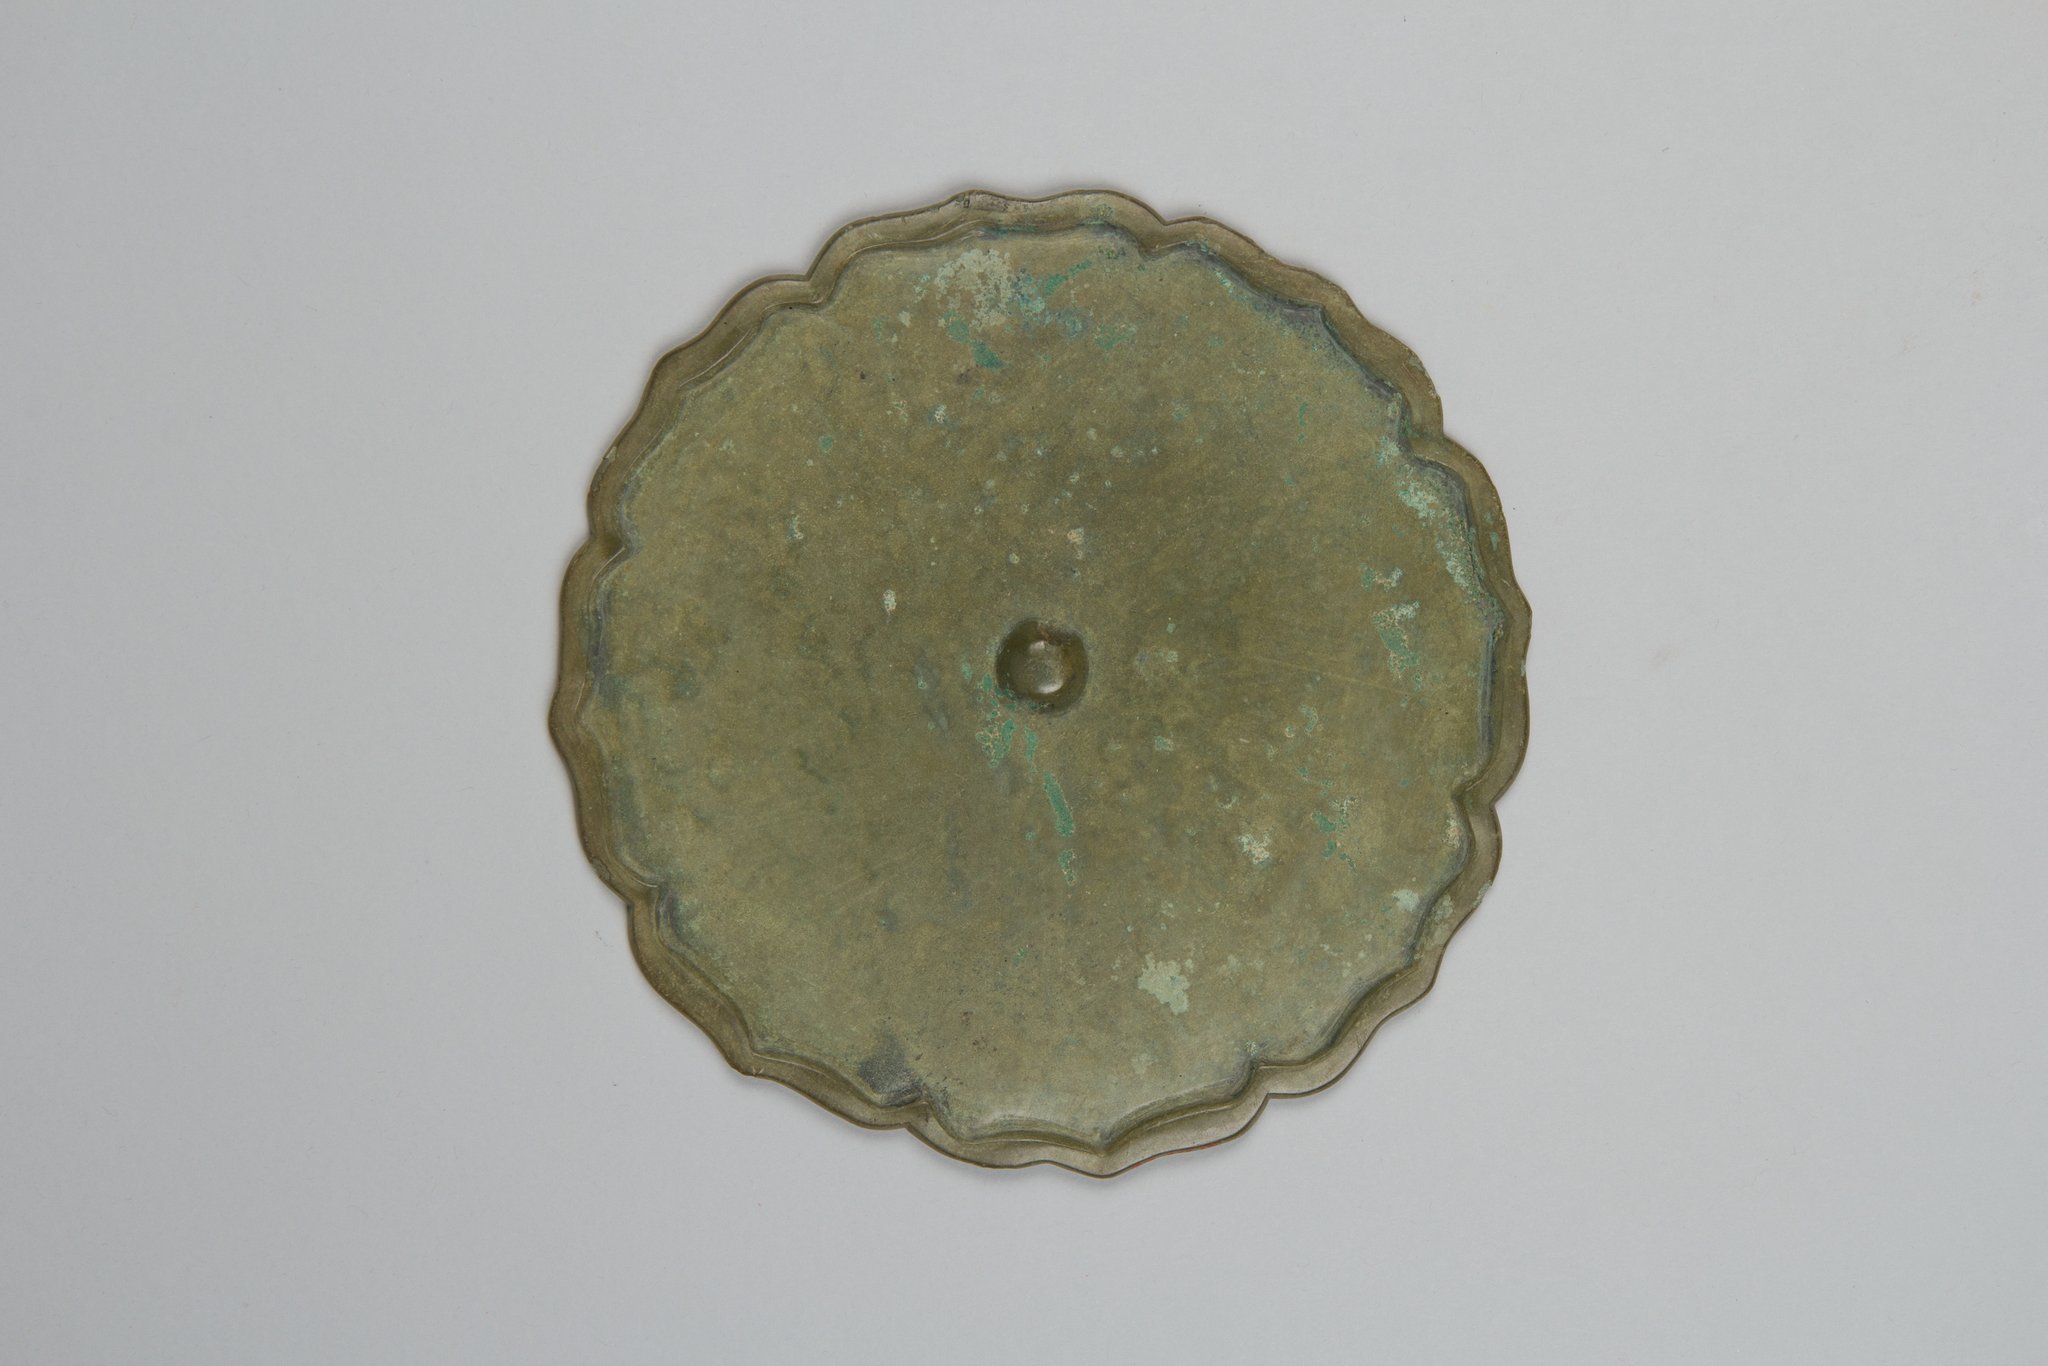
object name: mirror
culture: korean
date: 918-1392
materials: bronze